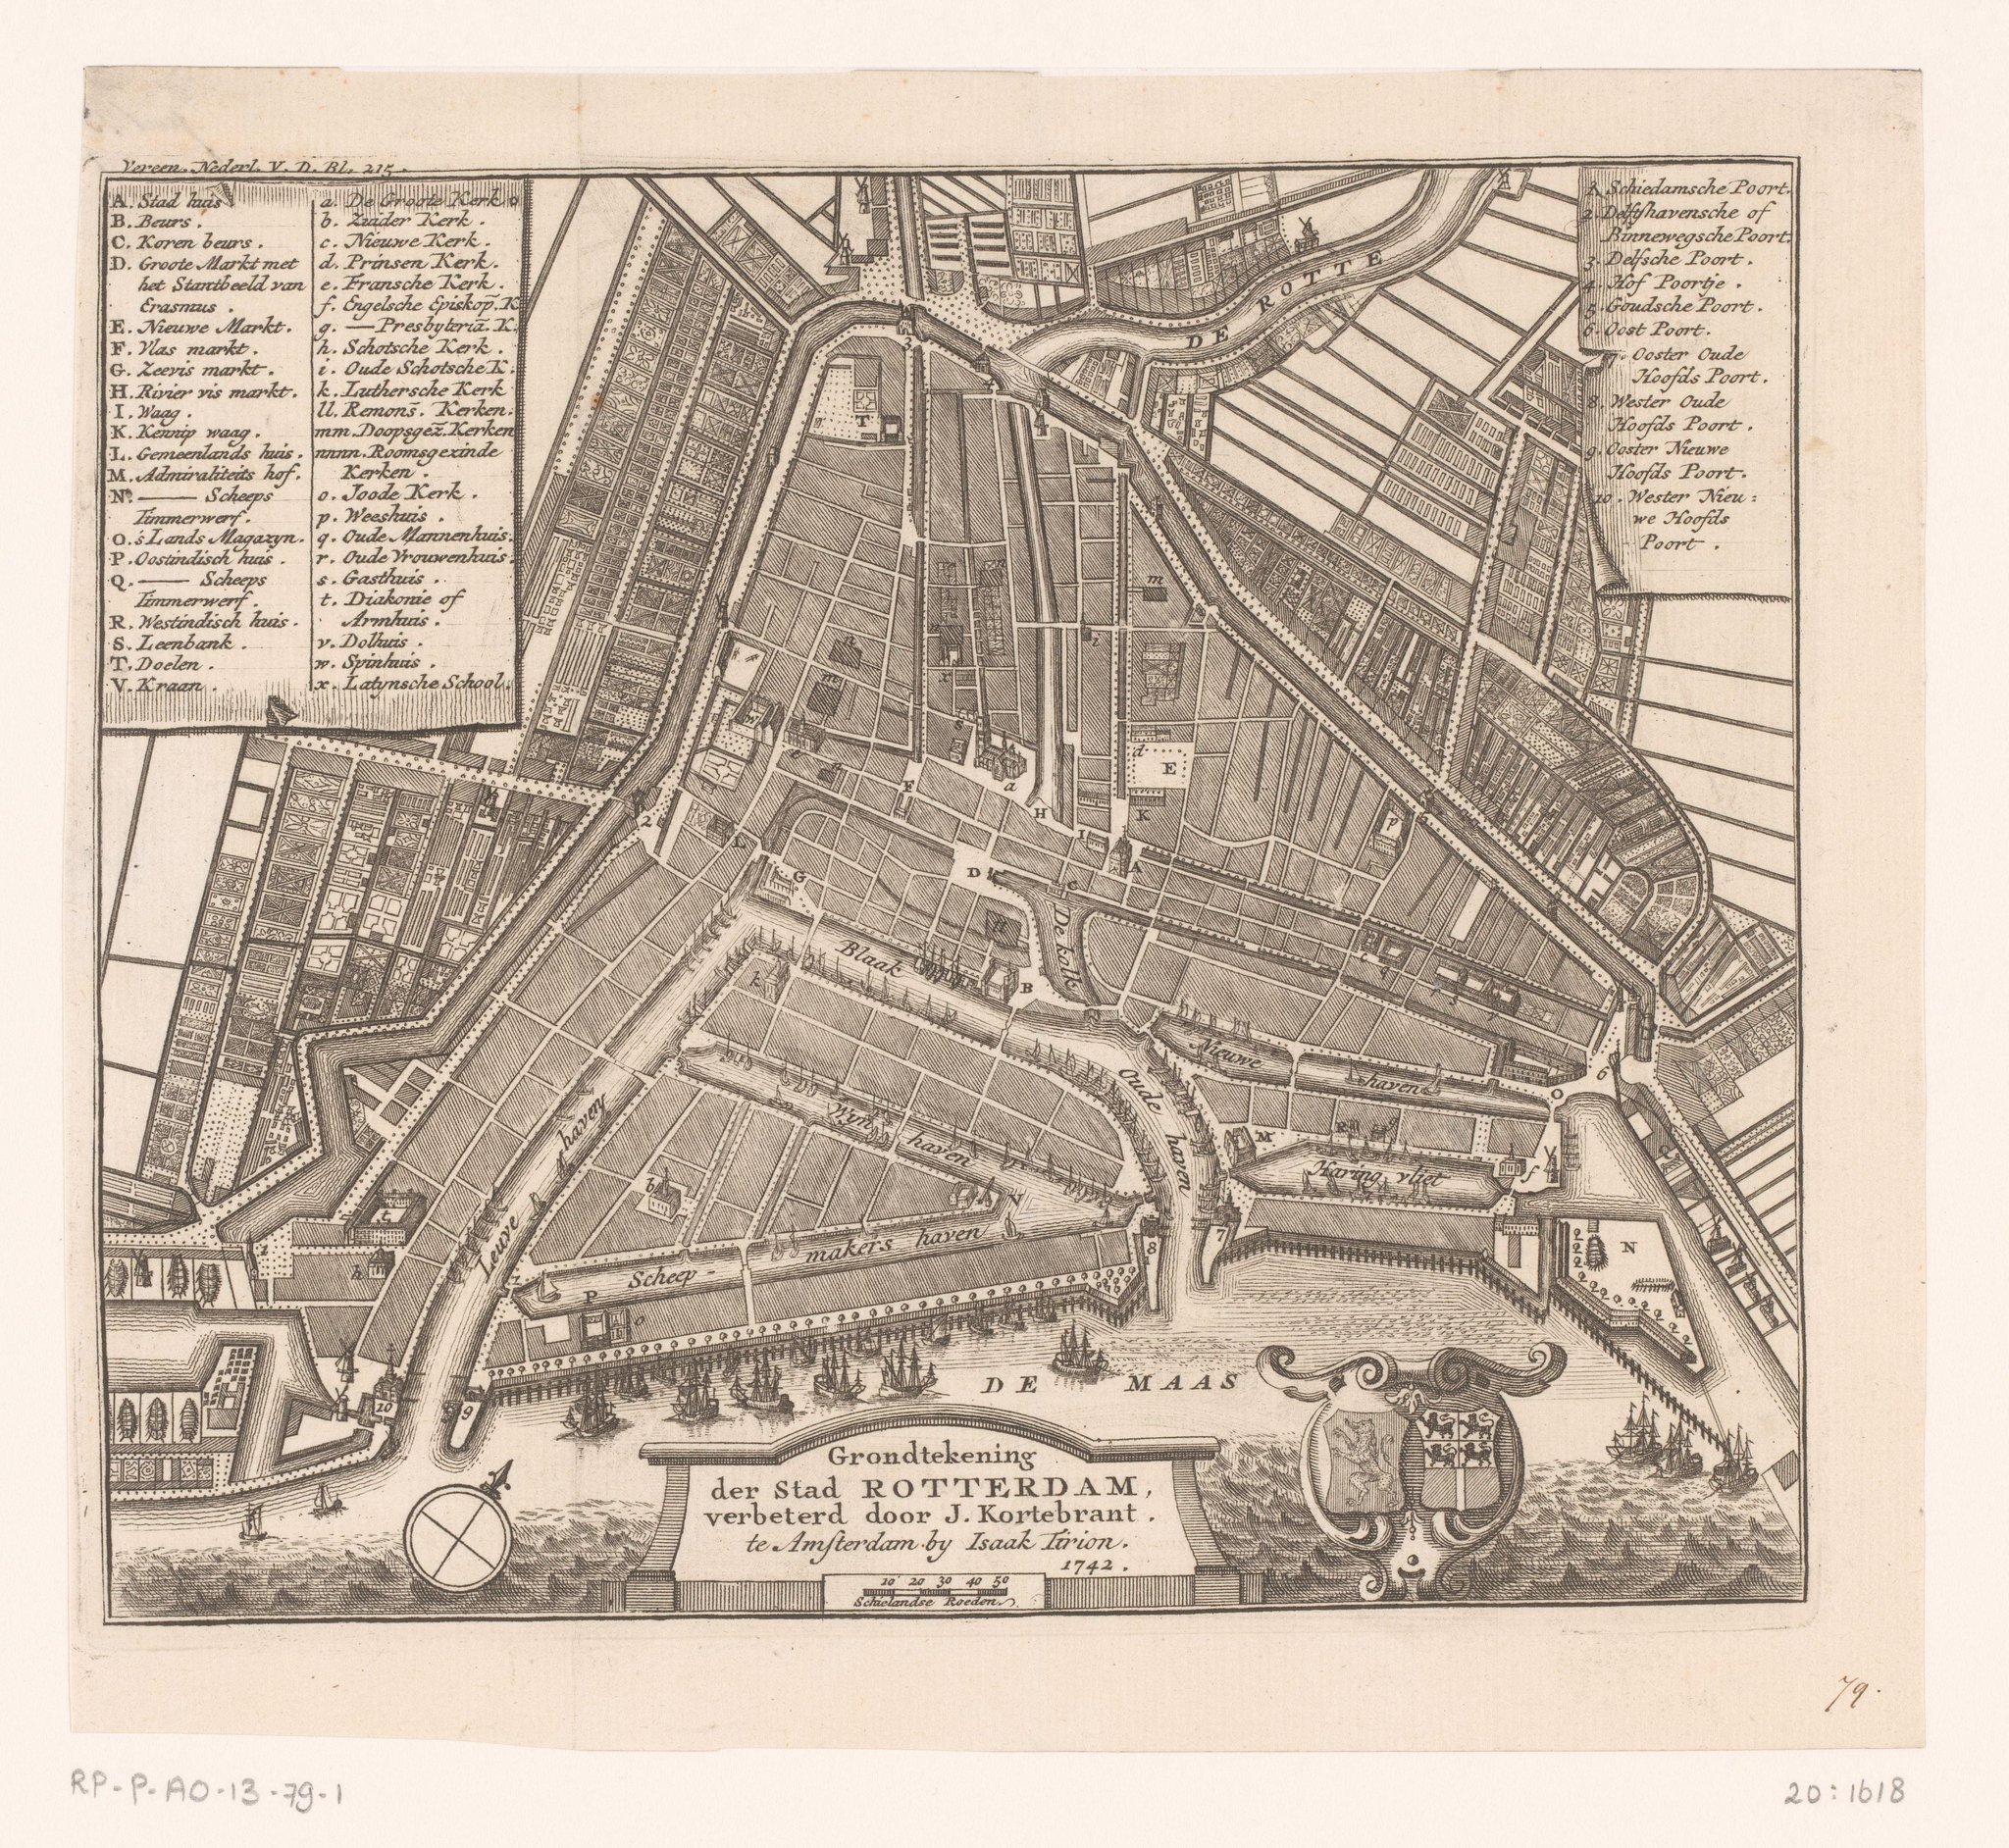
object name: print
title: Grondtekening der stad Rotterdam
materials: paper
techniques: engraving, etching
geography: amsterdam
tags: coat of arms (as symbol of the state, etc.) (+ city; municipal), maps of cities, coat of arms (as symbol of the state, etc.) (+ province; provincial), rotterdam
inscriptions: collector's mark: Lugt 2233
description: Prent ook gebruikt in: Wagenaar, Jan. Tegenwoordige staat der Vereenigde Nederlanden, vyfde deel. Behelzende het vervolg der beschrijvinge van Holland. Met naauwkeurige plans der steden en printverbeeldingen versierd / Hedendaagsche historie, of tegenwoordige staat van alle volkeren; XVde deel (…). Amsterdam: Isaak Tirion, 1744, tussen p. 214 en 215. En in: Beknopte atlas, van omtrent honderd platte gronden der voornaamste vestingen, kasteelen en steden van Europa, en byzonder van de Nederlanden en eenige kolonien (…). Amsterdam: Compagnie van Boekverkopers, s.a. [na 1780].